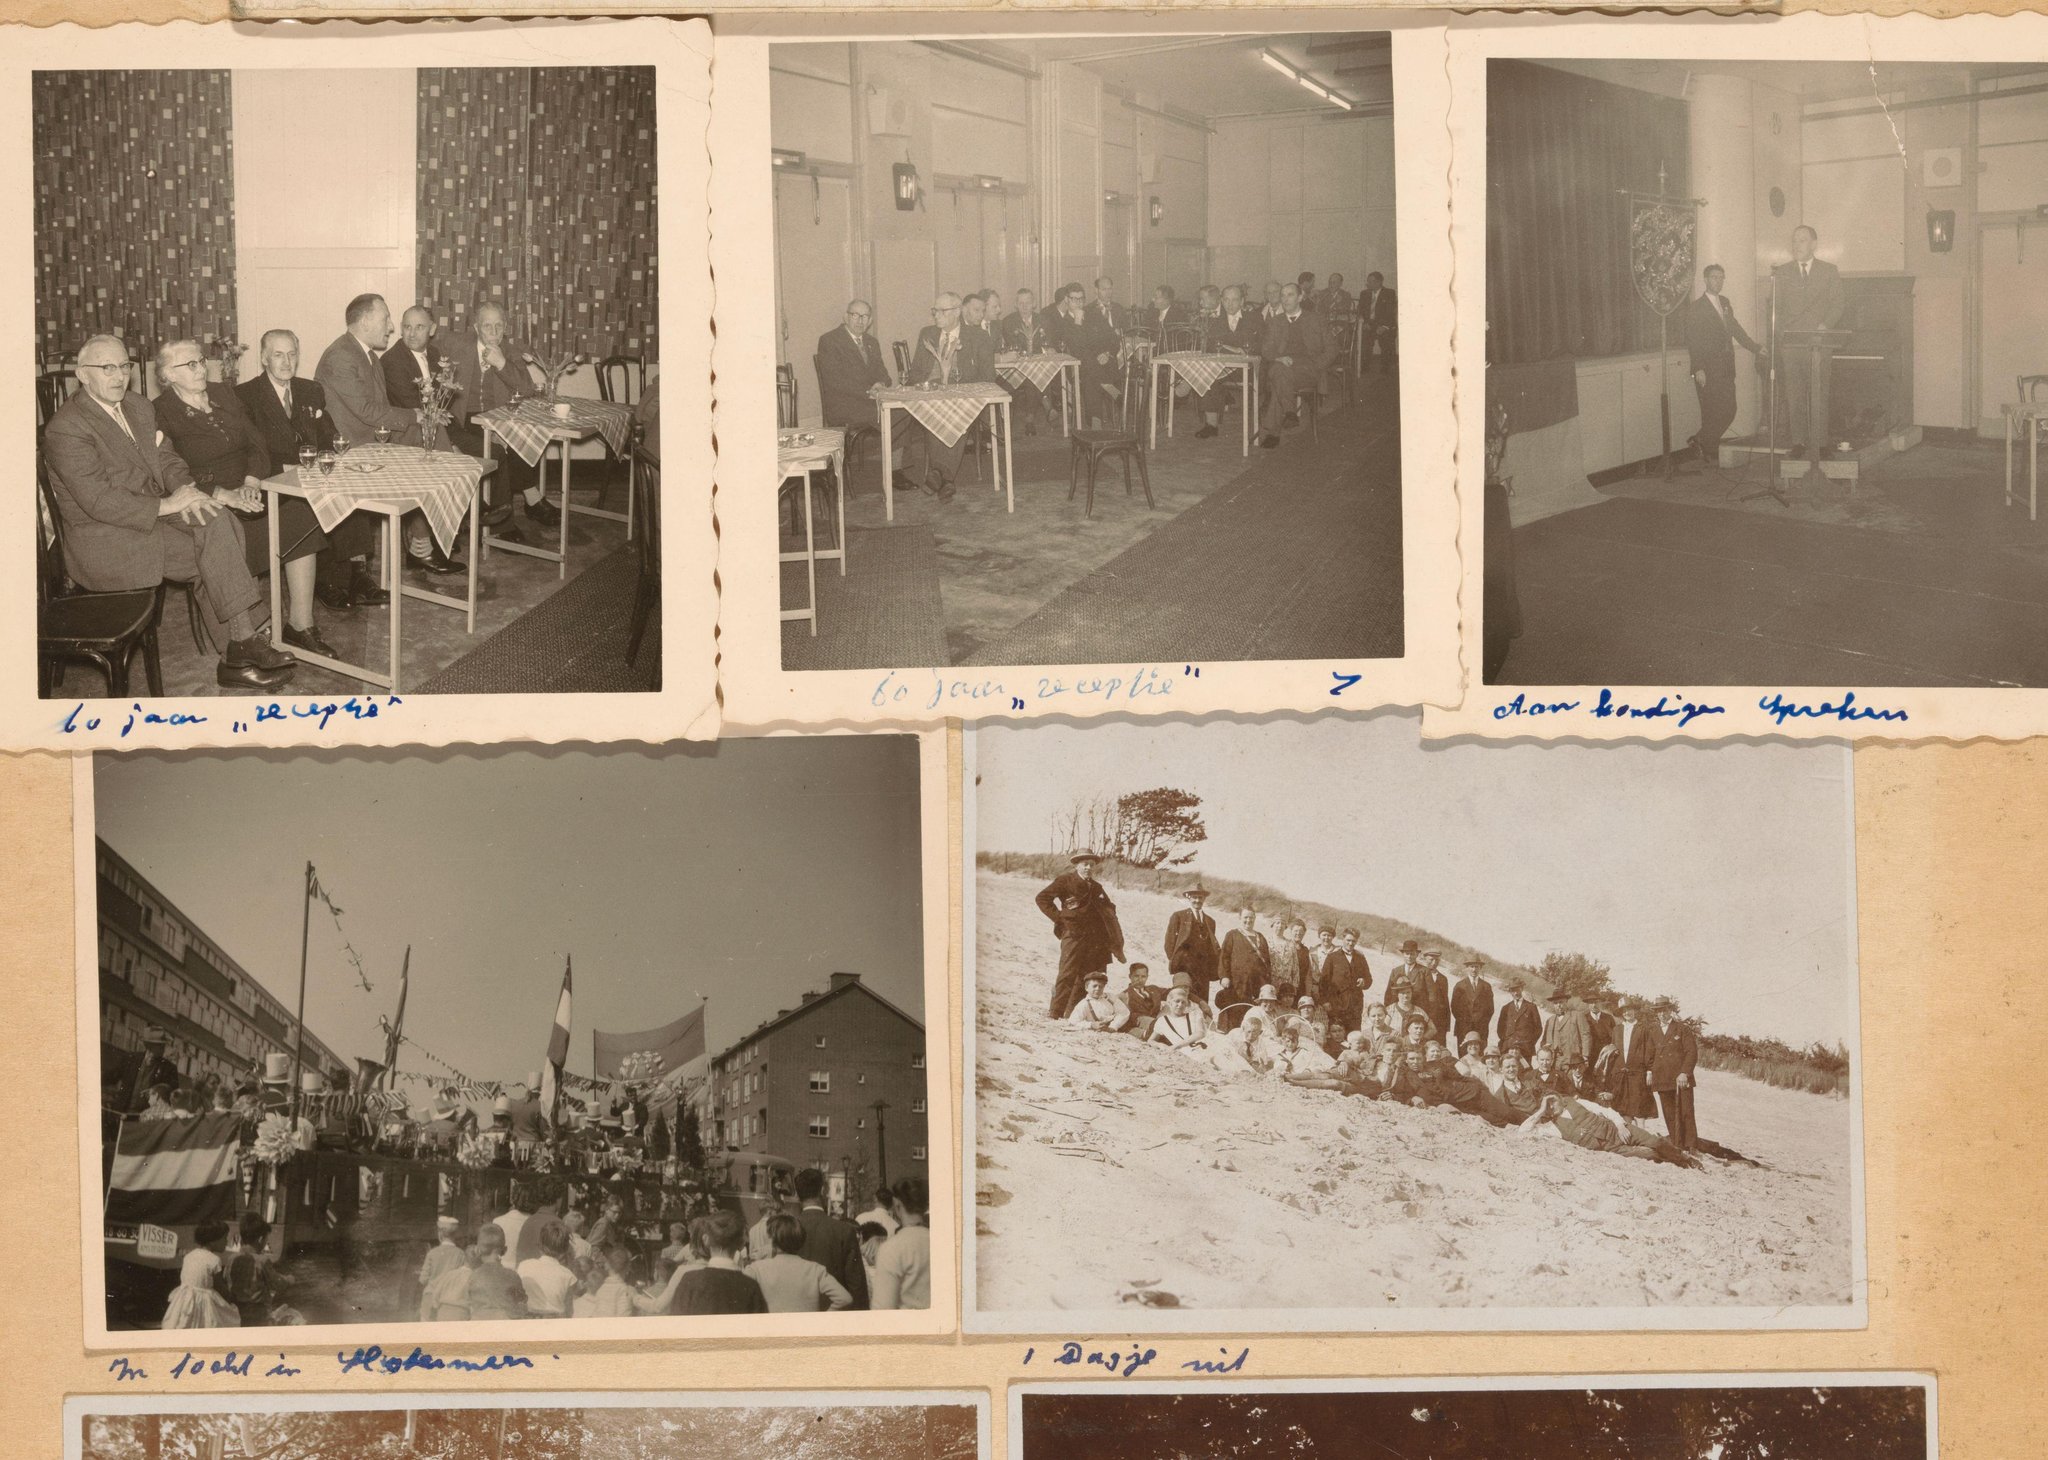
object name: photograph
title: Groepsportret tijdens de receptie van muziekvereniging 'Crescendo' ter gelegenheid van het 60-jarig bestaan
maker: Anonymous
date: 1961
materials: cardboard, photographic support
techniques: gelatin silver print